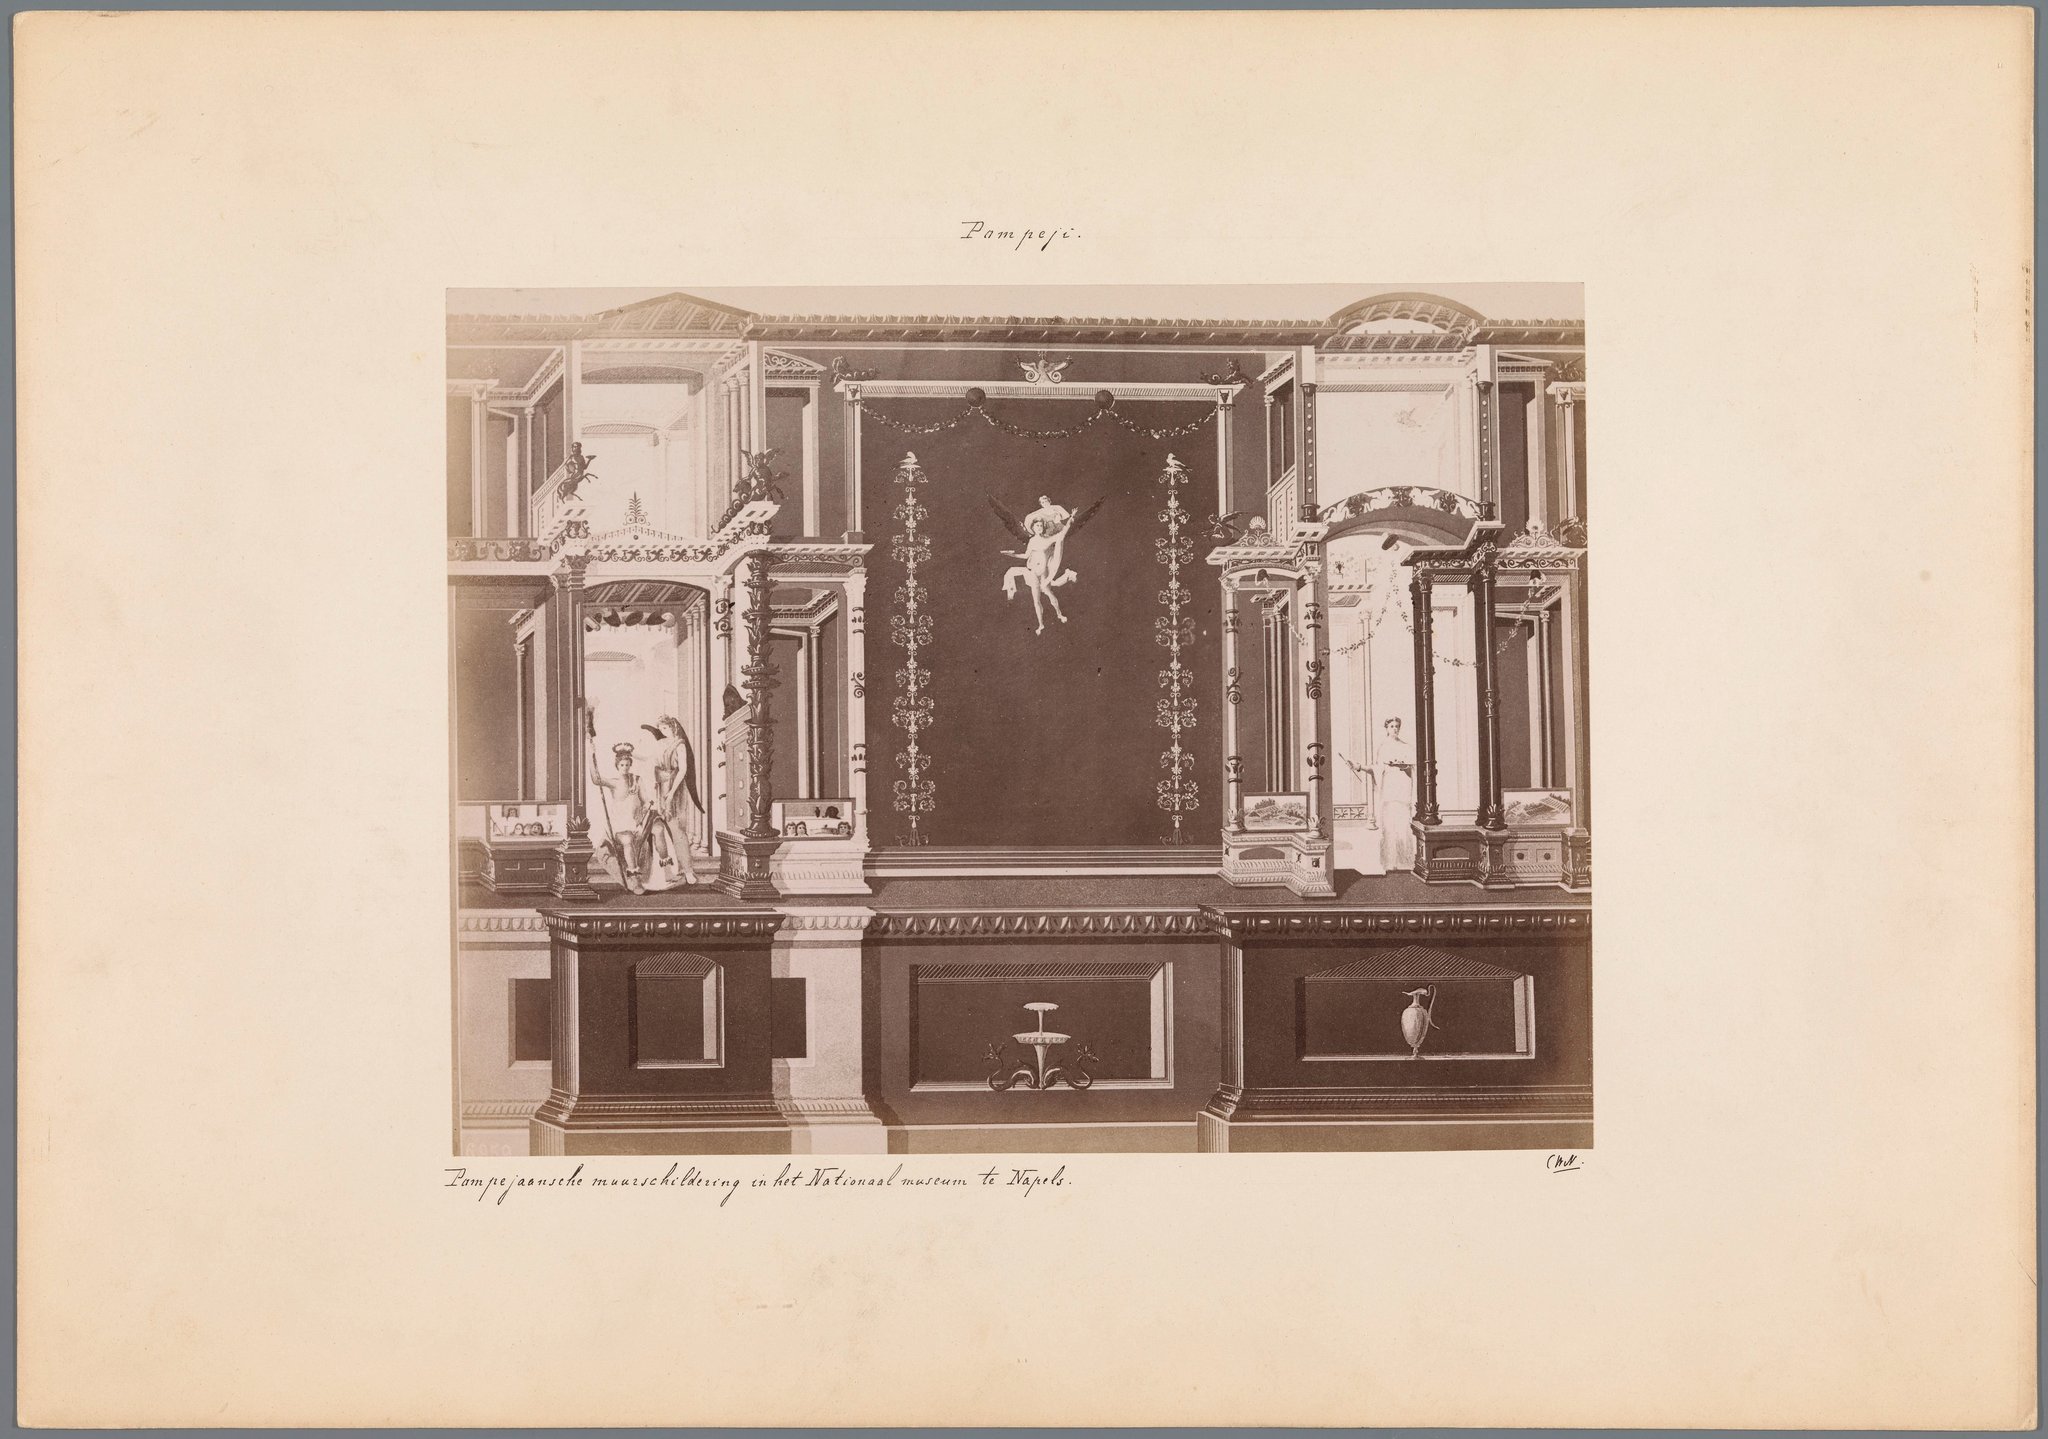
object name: reproduction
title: Fotoreproductie van (vermoedelijk) een tekening van een fresco afkomstig uit Pompeï, gedecoreerd met architectonische ornamenten en goden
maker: Anonymous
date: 1875-1900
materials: cardboard, photographic support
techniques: albumen print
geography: pompeii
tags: drawing, sketch, painting (including book-illumination, miniature-painting) (+ plaster ~ arts), ornament derived from architectural details, pompeii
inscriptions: collector's mark: ‘INSTITUUT VOOR KUNST-NIJVERHEIDSONDERWIJS GABRIËL METSUSTRAAT No. 16 AMSTERDAM’, inscription: ‘Pompeji.’, inscription: ‘CWN.’, number: ‘6959’, collector's mark: ‘KUNSTNIJVERHEIDSCHOOL QUELLINUS AMSTERDAM FRANS HALSSTRAAT 14.’